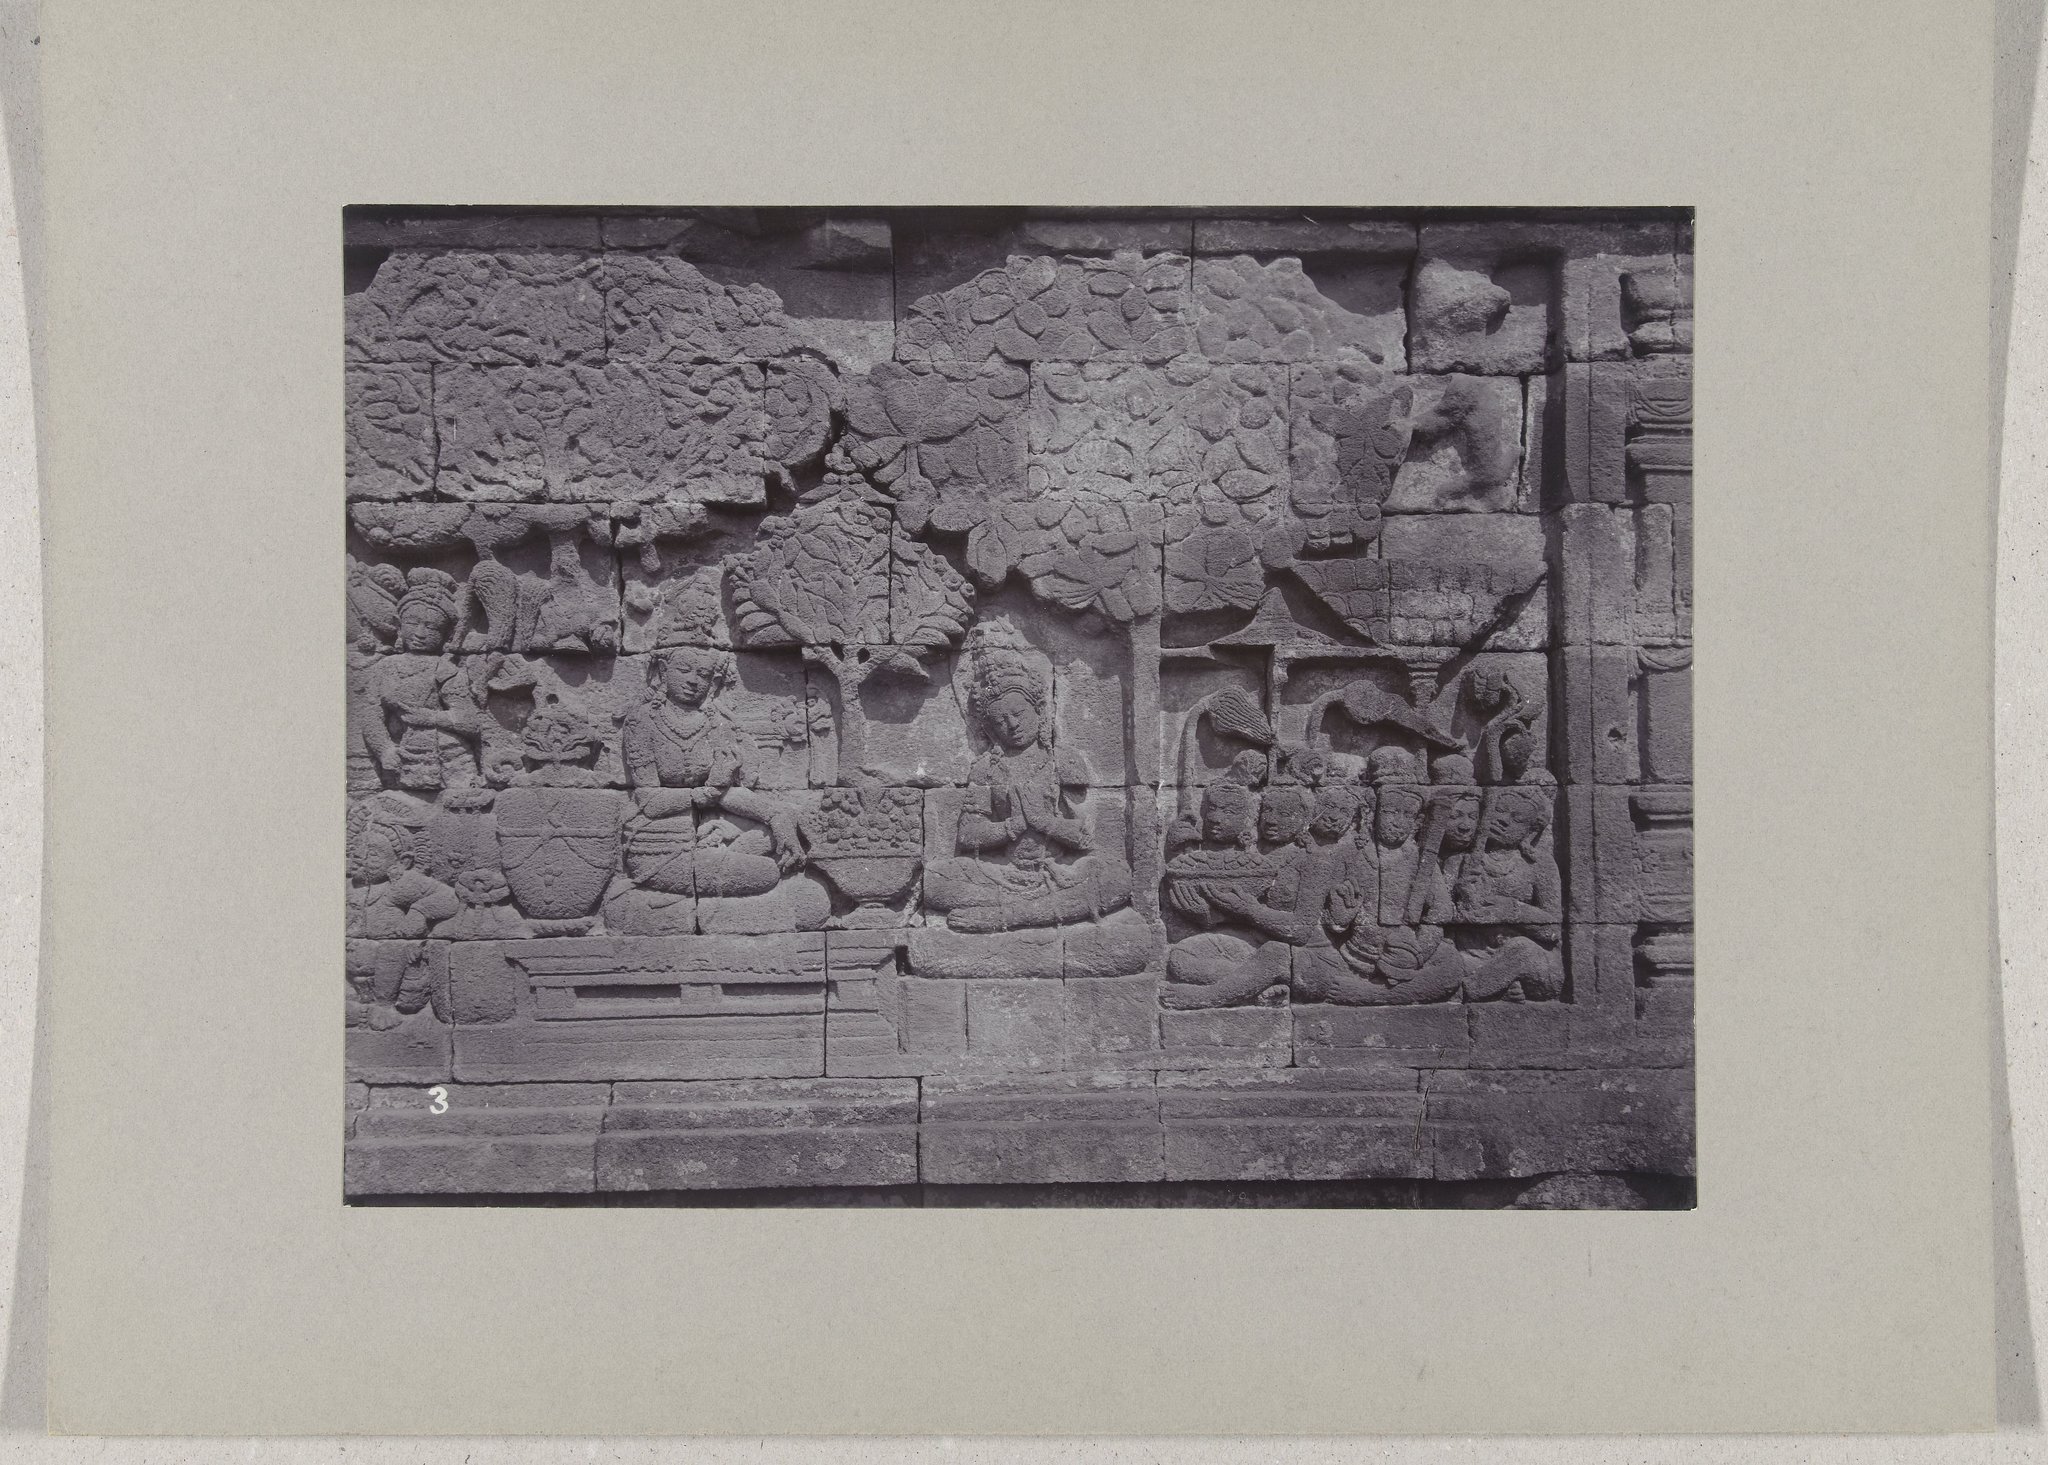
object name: photograph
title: Reliëf van de Borobudur (Boroboedoer), nabij Magelang, Nederlands-Indië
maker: onnes kurkdjian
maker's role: fotograaf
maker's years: 1851-1903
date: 1895-1915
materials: cardboard, paper, photographic support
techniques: gelatin silver print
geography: magelang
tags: borobudur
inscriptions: number: ‘3’, annotation: ‘83. Boroboedoer’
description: Reliëf van de Borobudur (Boroboedoer), nabij Magelang, Nederlands-Indië